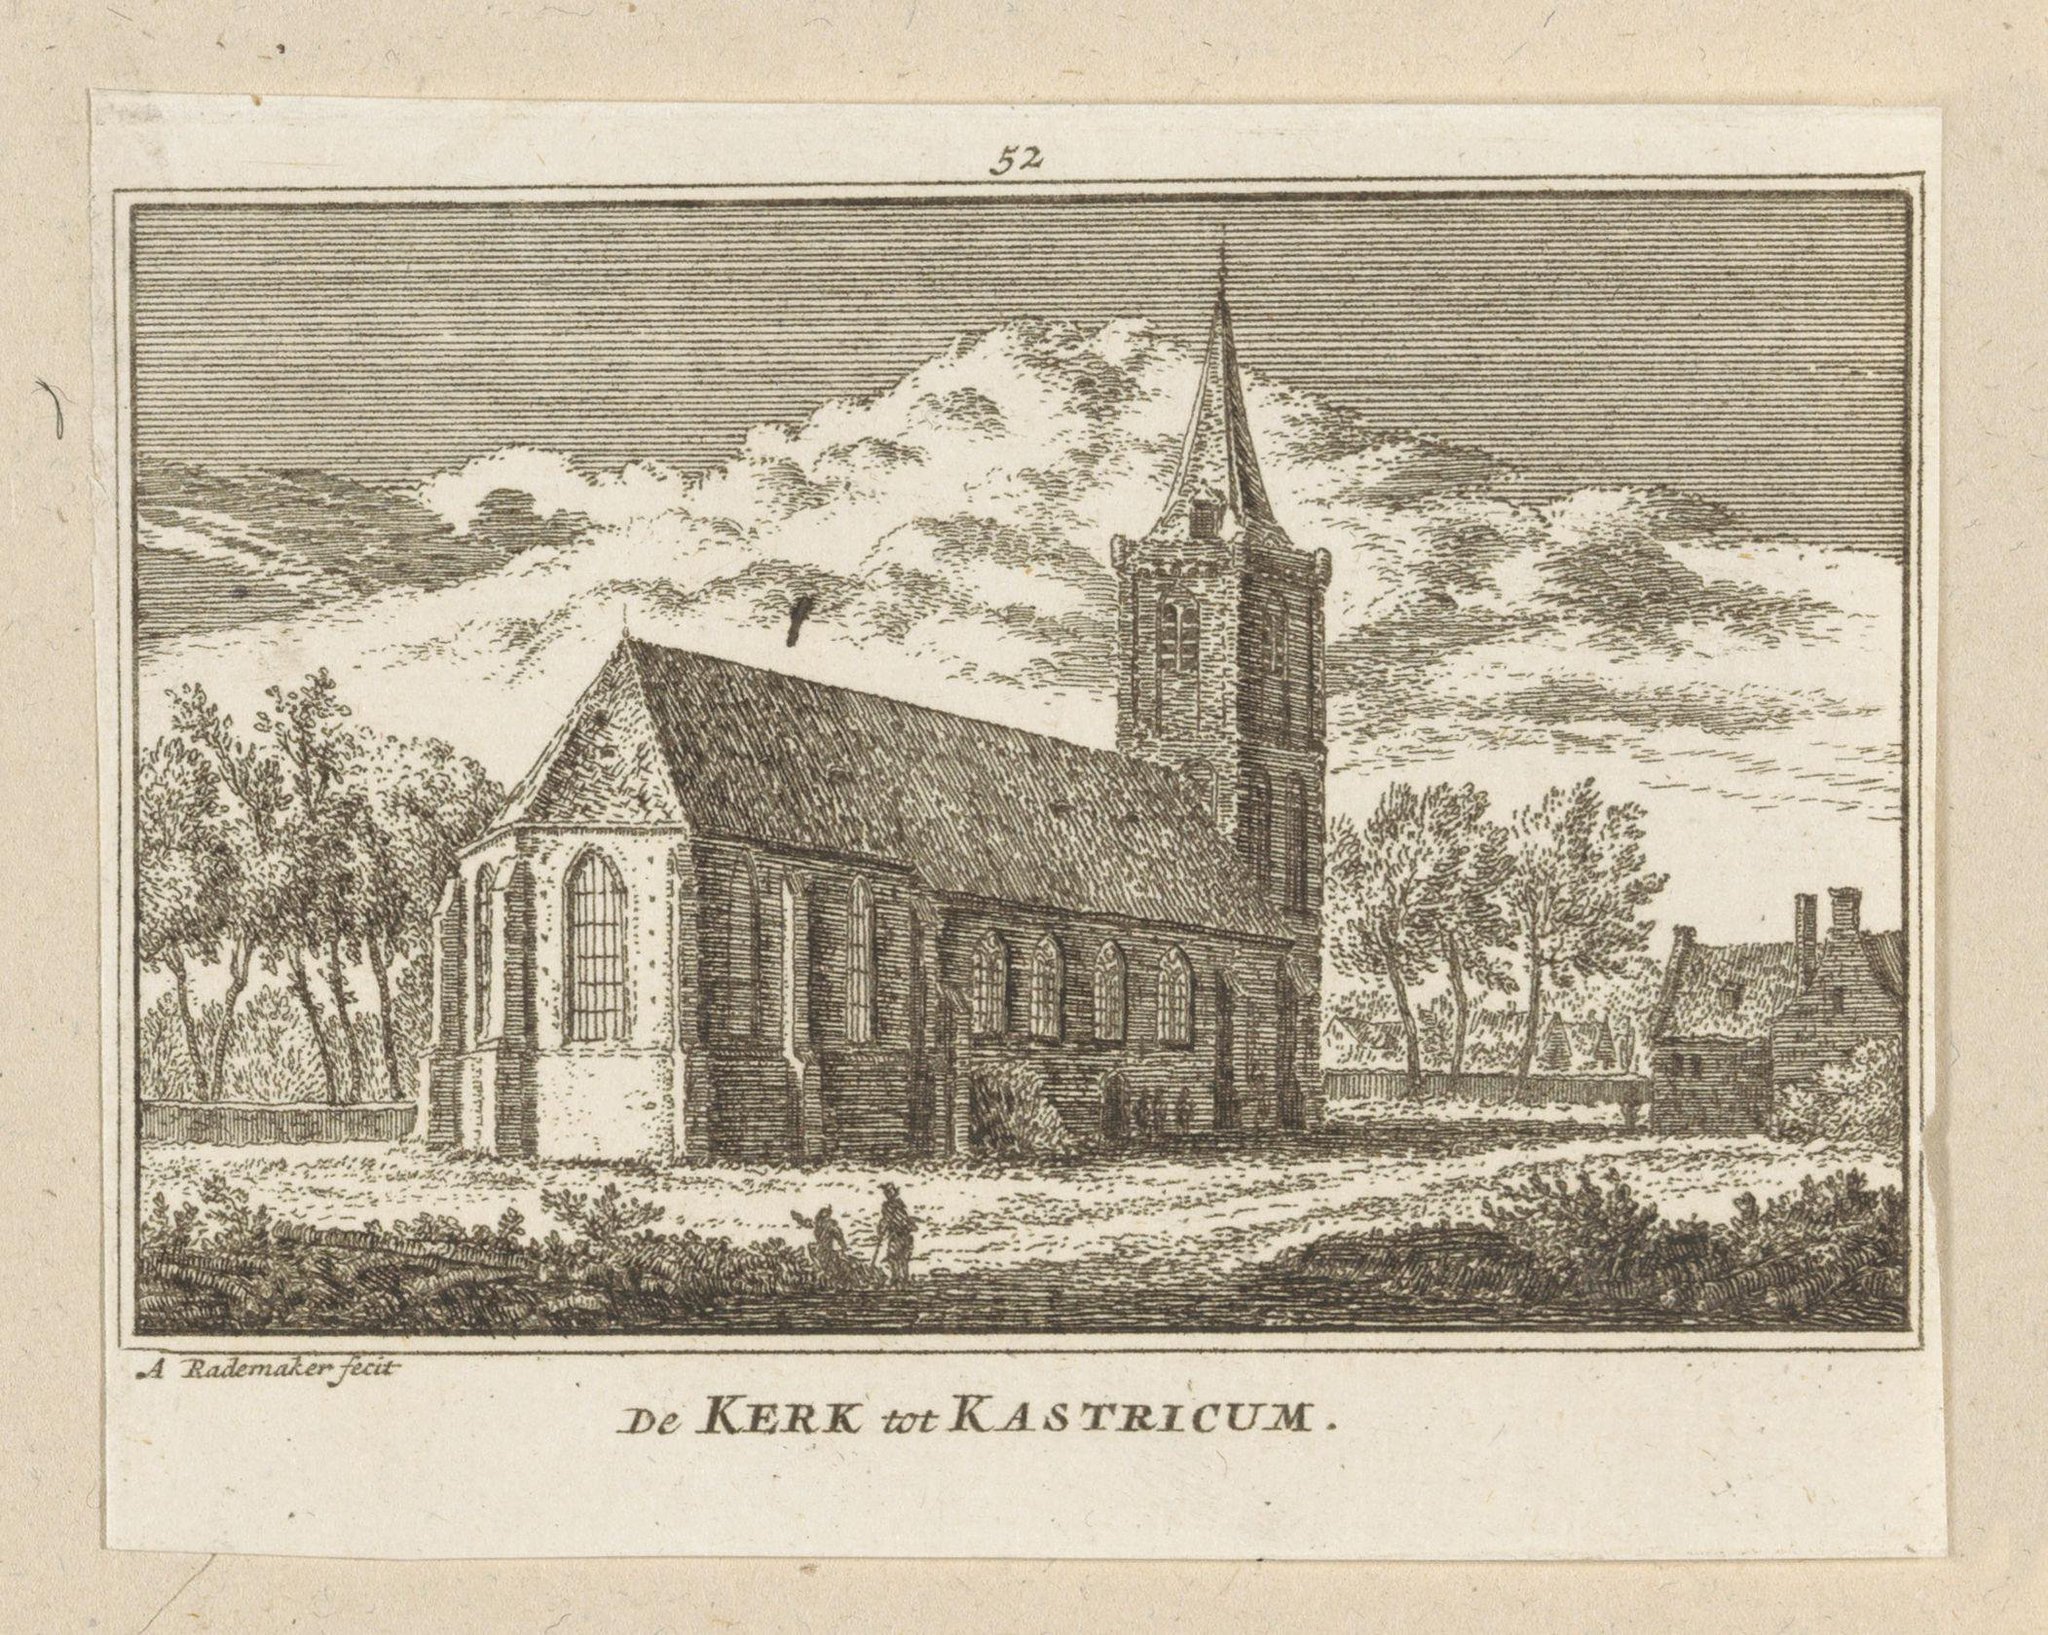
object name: print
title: De kerk tot Kastricum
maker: abraham rademaker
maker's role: draughtsman, print maker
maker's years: 1676-1735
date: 1725-1803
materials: paper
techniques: engraving, etching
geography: amsterdam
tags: church (exterior)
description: Prent ook gebruikt in: Rademaker, Abraham. Kabinet van Nederlandsche outheden en gezichten: vervat in 300 konstplaaten (…). 2 delen. Amsterdam: Willem Barents, 1725, dl. 1, ill. 52. Na 1725 is deze prent nog in verschillende heruitgaven verschenen, uitgegeven in 1727-1733, 1770-1771 en 1792-1803. Uit welke uitgave het huidige exemplaar precies komt is niet na te gaan.